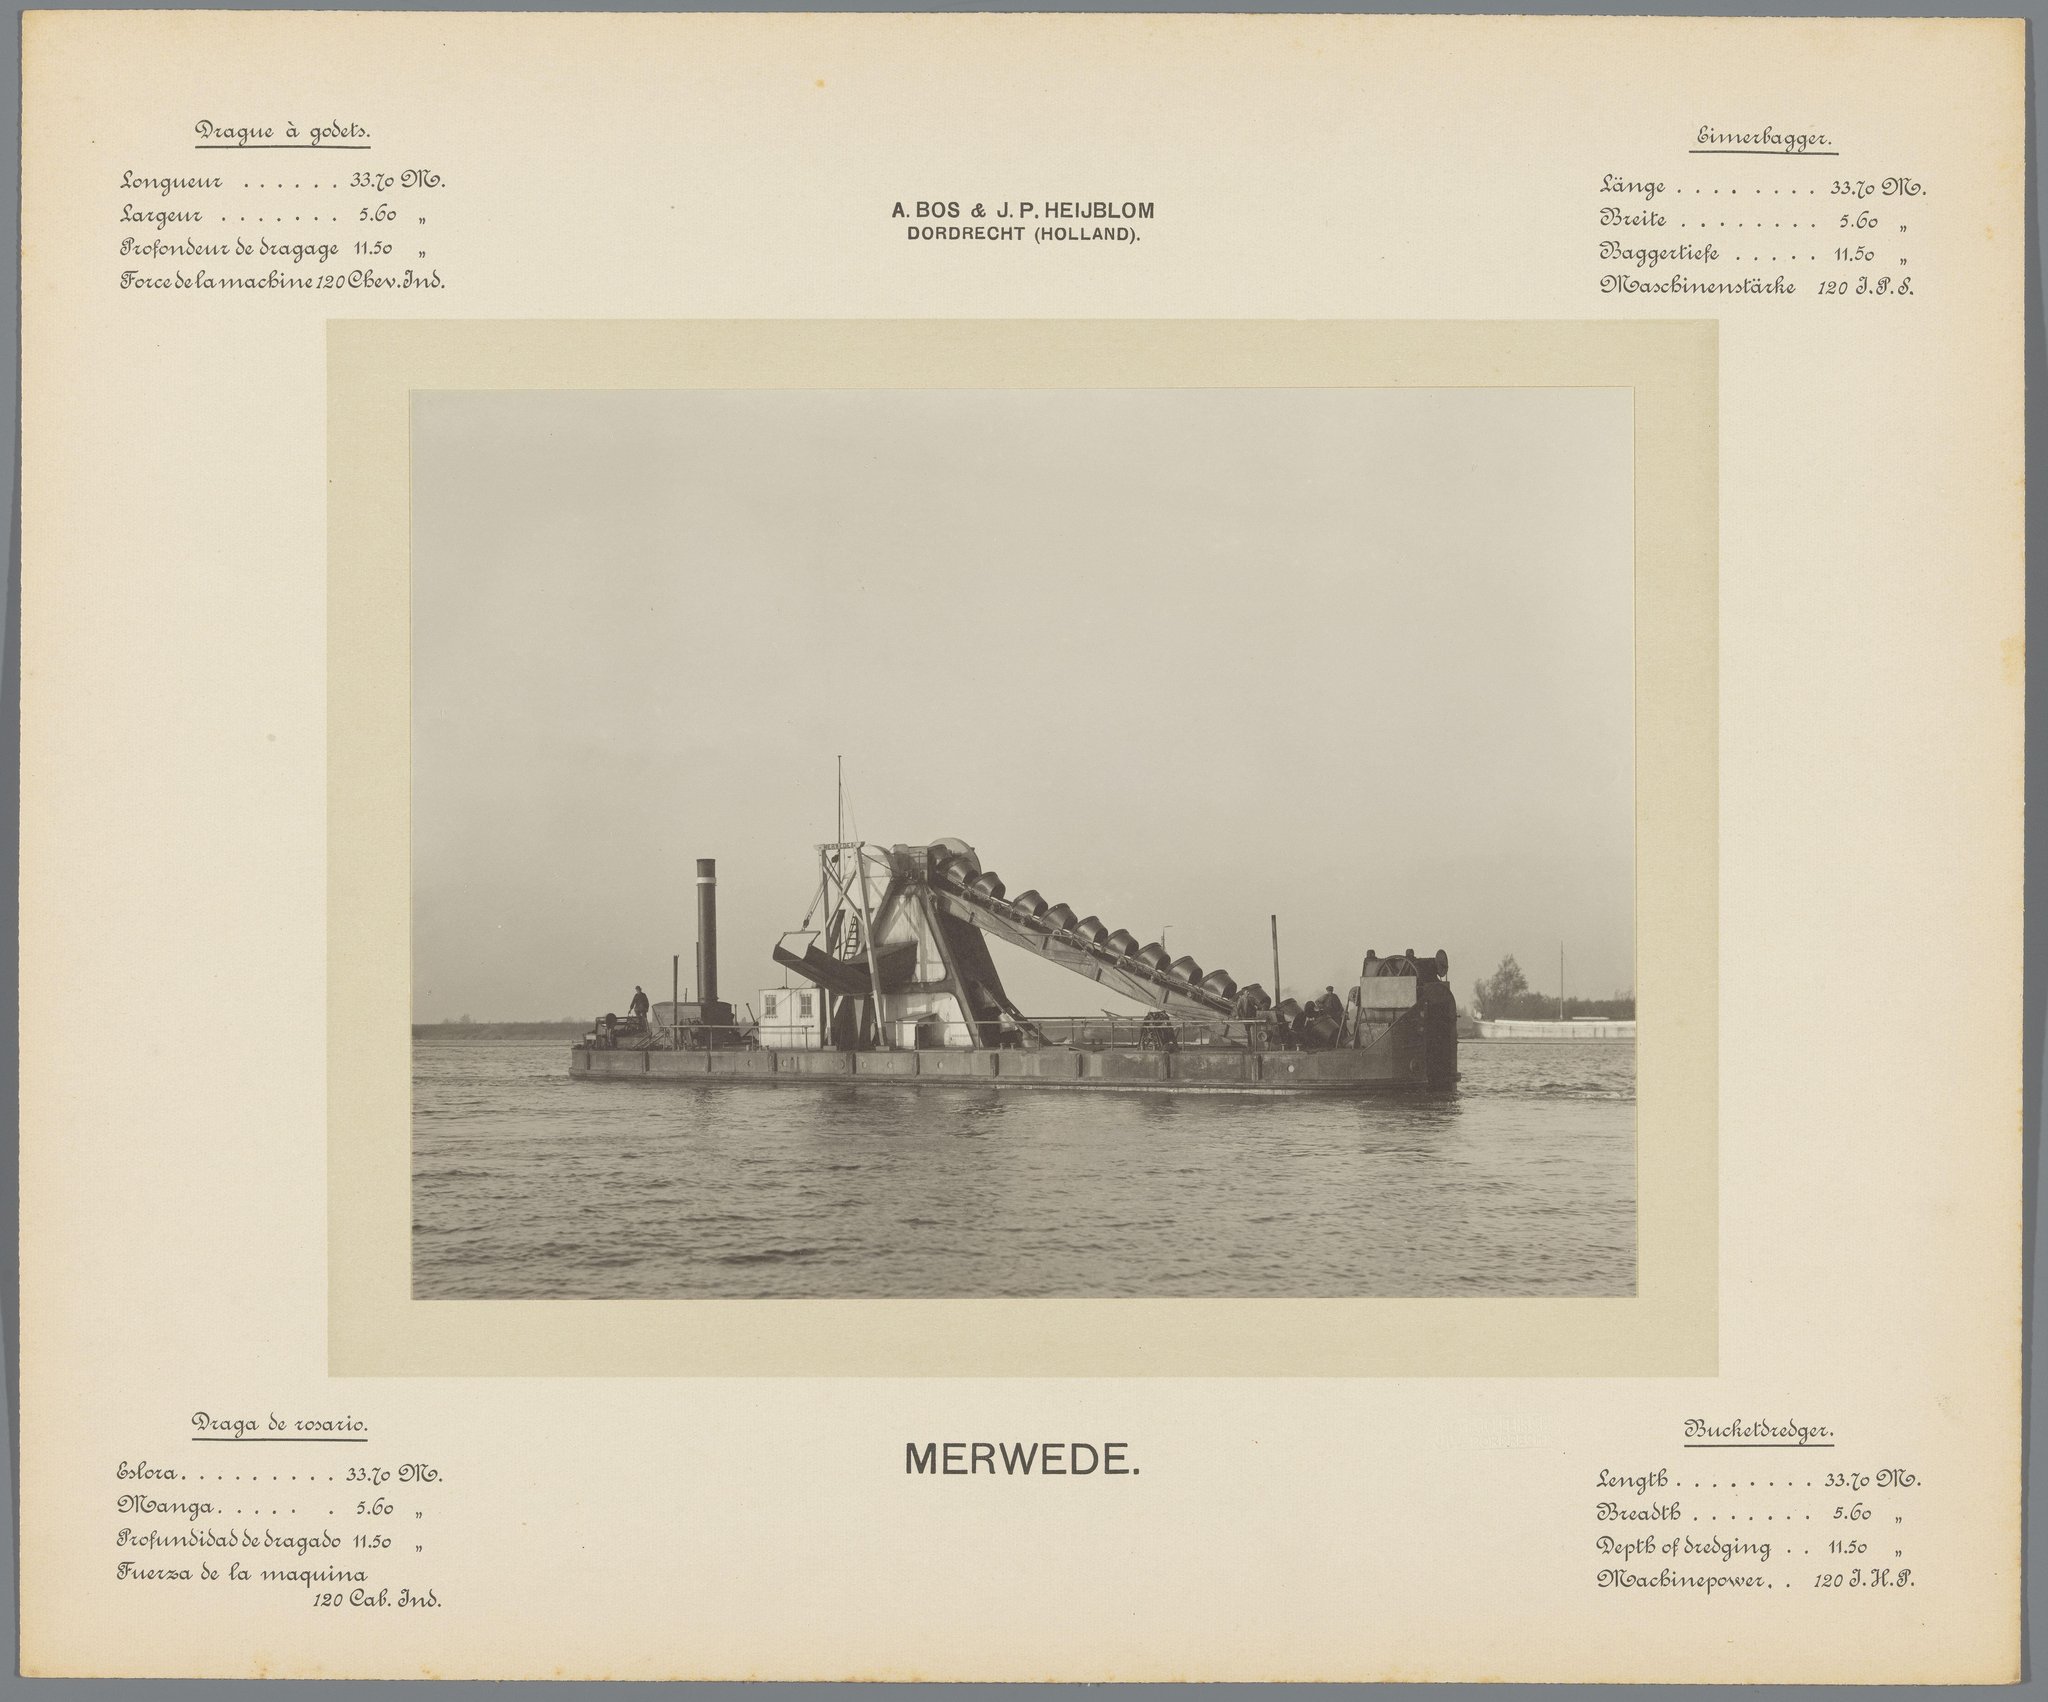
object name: photograph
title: Merwede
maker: henricus jacobus tollens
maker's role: painter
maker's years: 1864-1936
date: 1900-1910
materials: cardboard, photographic support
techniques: gelatin silver print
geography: dordrecht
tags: machine driven by steam, steamship, motorship (+ propulsion of vehicle, ship, etc. by steam), dredge, dredging machine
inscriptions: name: ‘H.J. Tollens C. Hzn. Dordrecht’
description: Emmerbaggermolen Merwede. Foto geplakt op karton met technische informatie over het schip in Duits, Frans, Spaans en Engels. Onderdeel van de map met 44 foto's van baggerschepen van de firma A. Bos & J.P. Heijblom te Dordrecht.